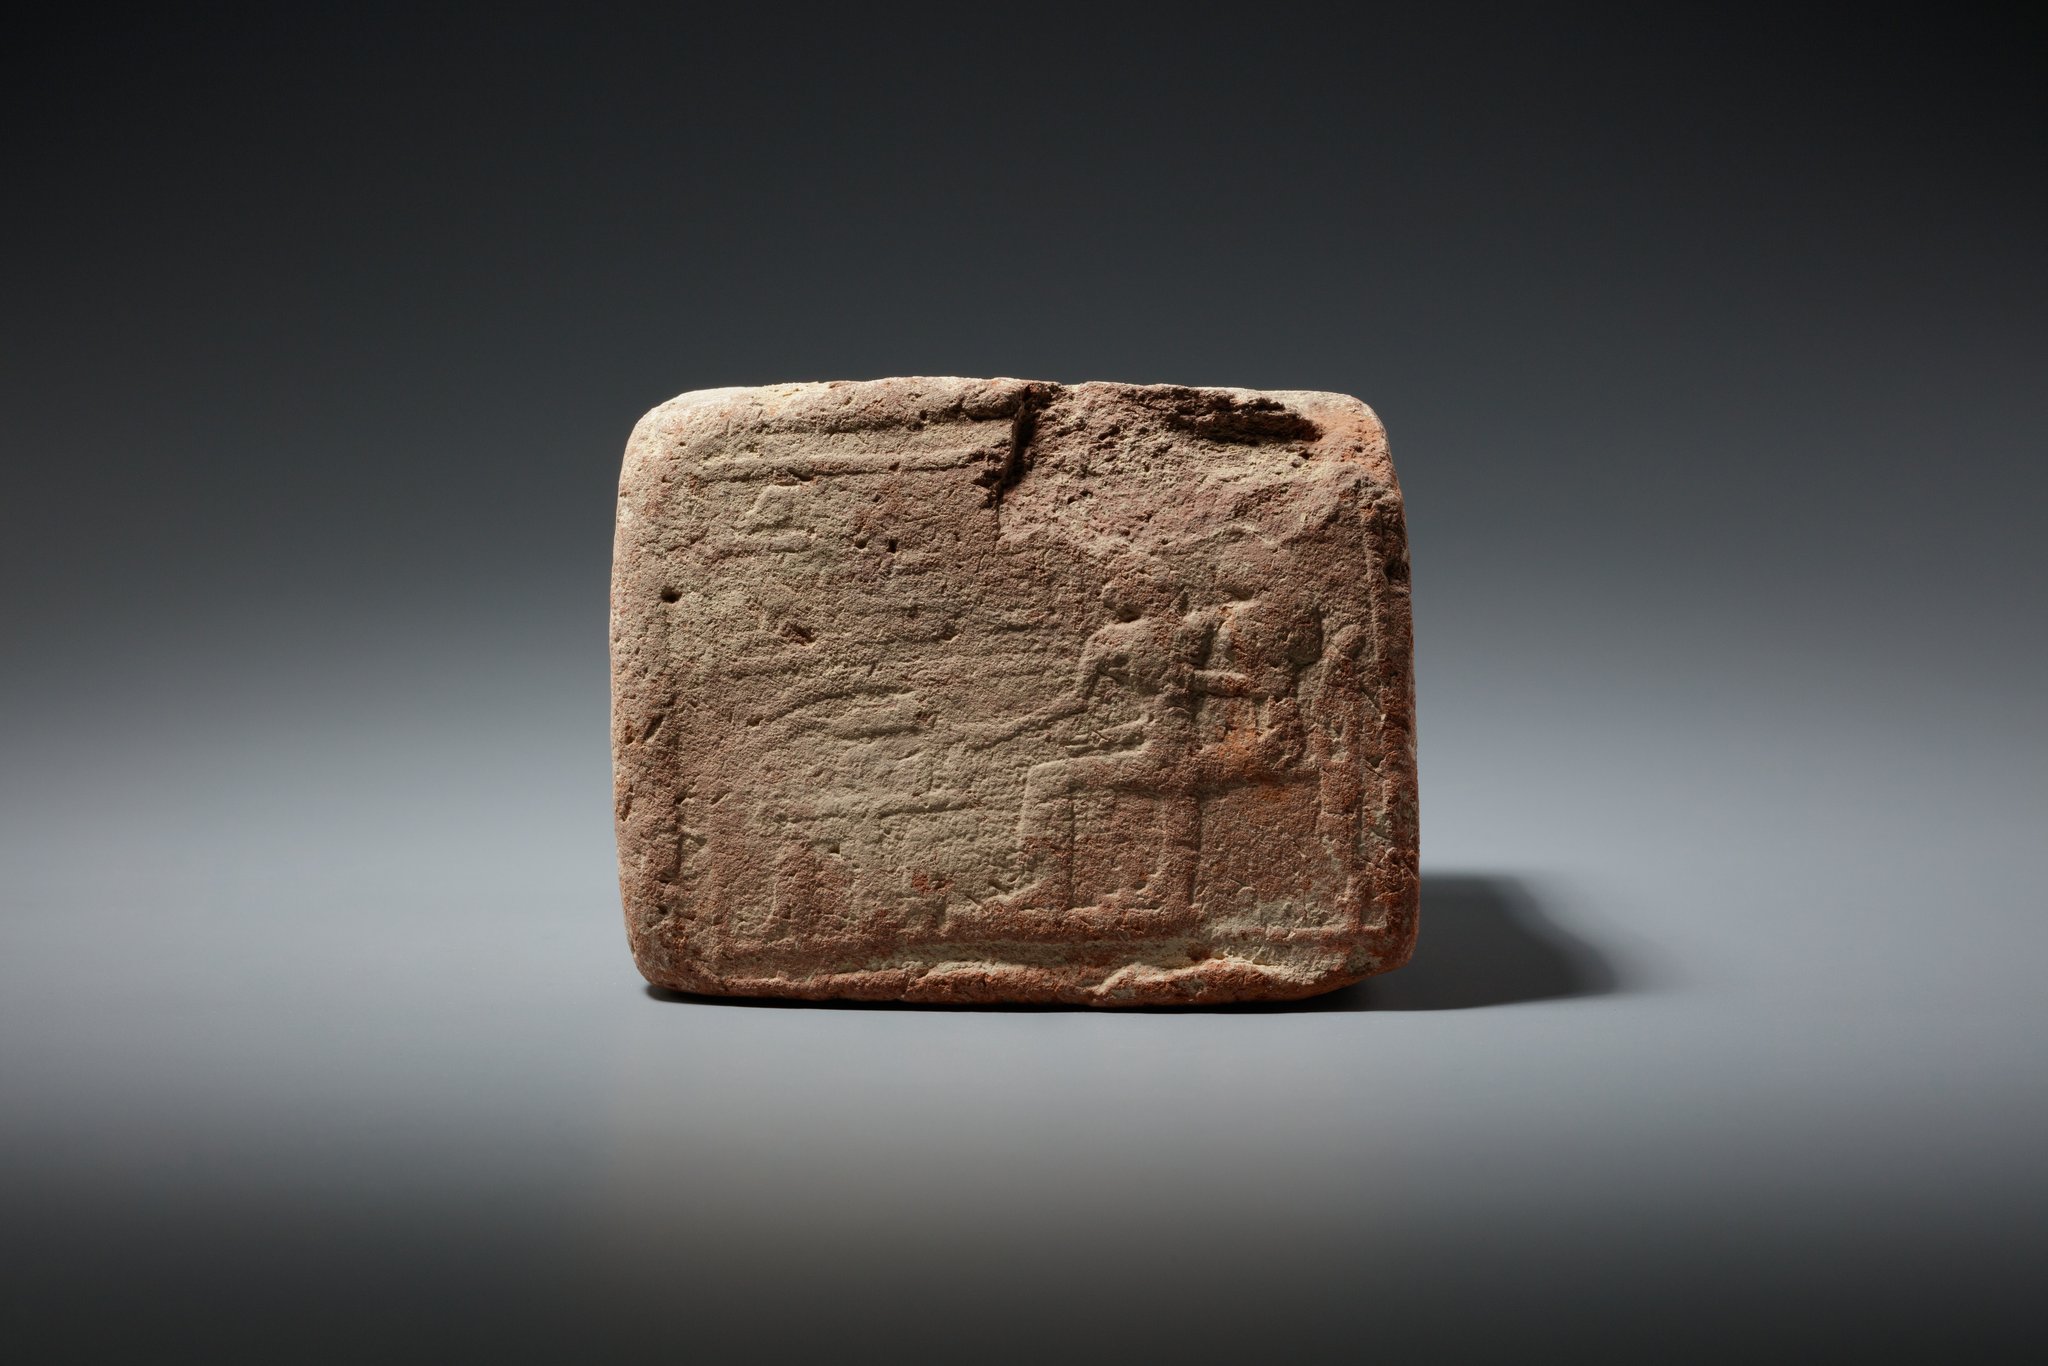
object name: cone, davy 599, aanu, sennu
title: Funerary Cone of Aanu and His Wife Sennu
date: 1550-1295 BCE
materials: pottery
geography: egypt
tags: human figures,hieroglyphs